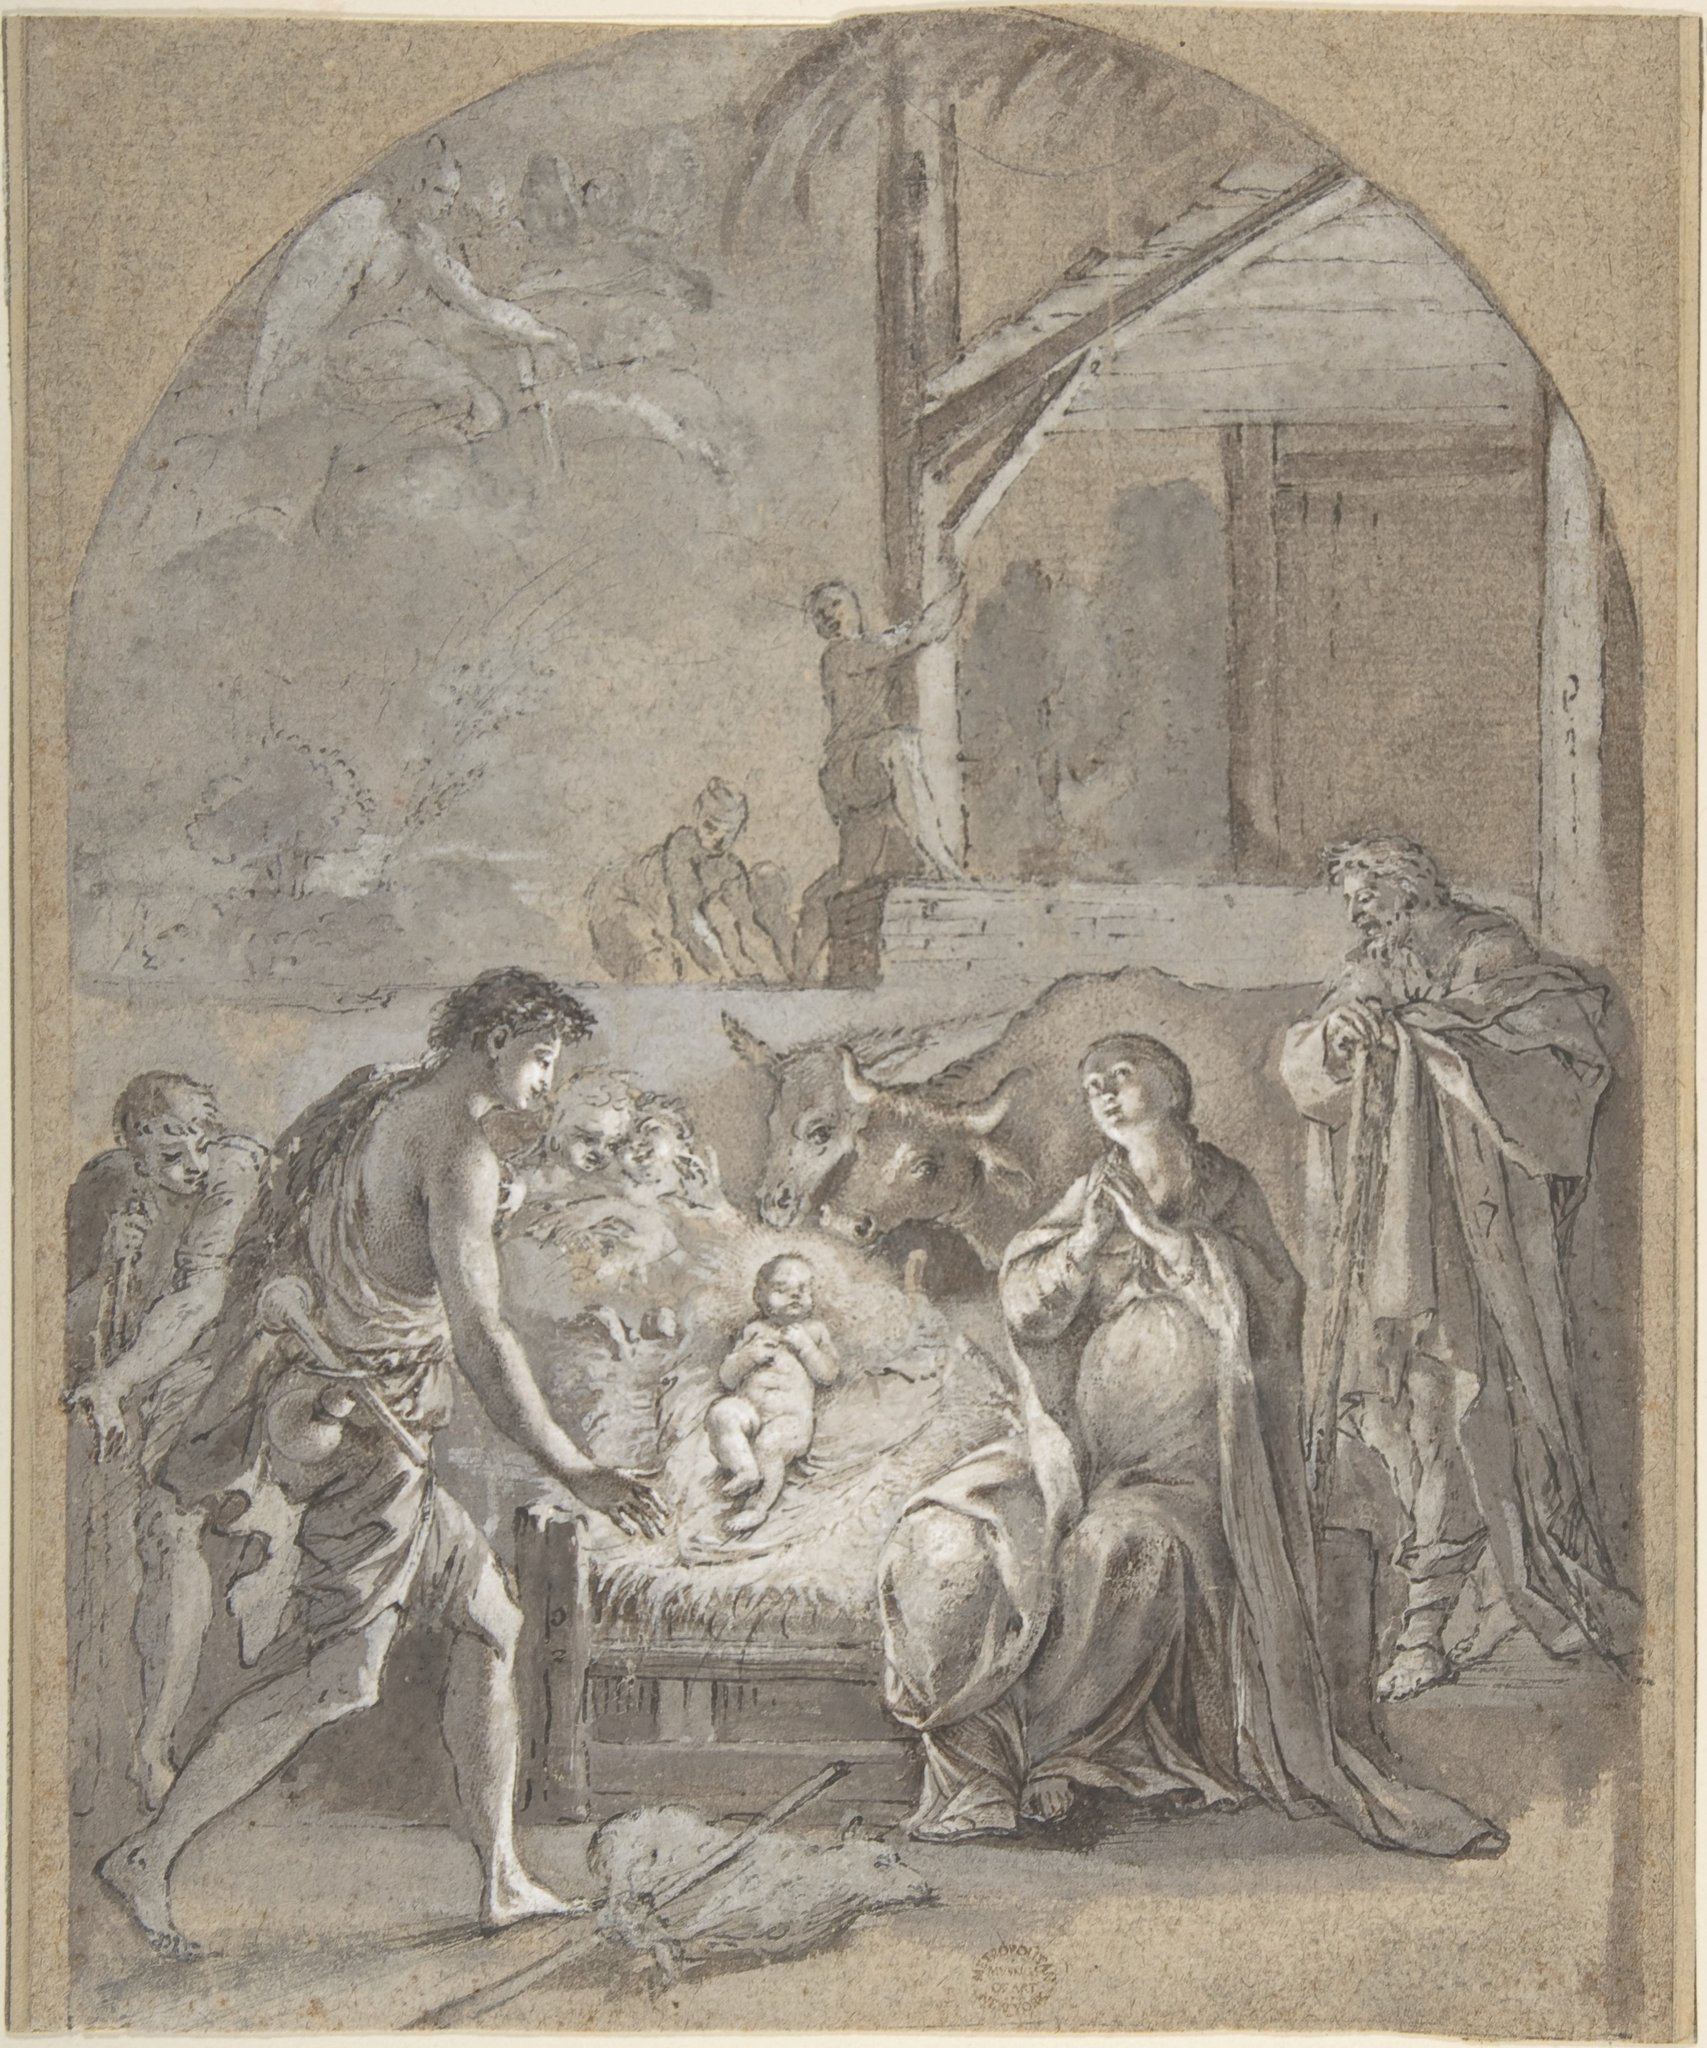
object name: drawing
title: Adoration of the Shepherds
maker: anonymous, italian, 18th century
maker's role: artist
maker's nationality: italian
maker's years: 1700-1800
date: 1701-1800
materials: gouache, ink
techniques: pen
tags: men,women,cows,jesus,adoration of the shepherds